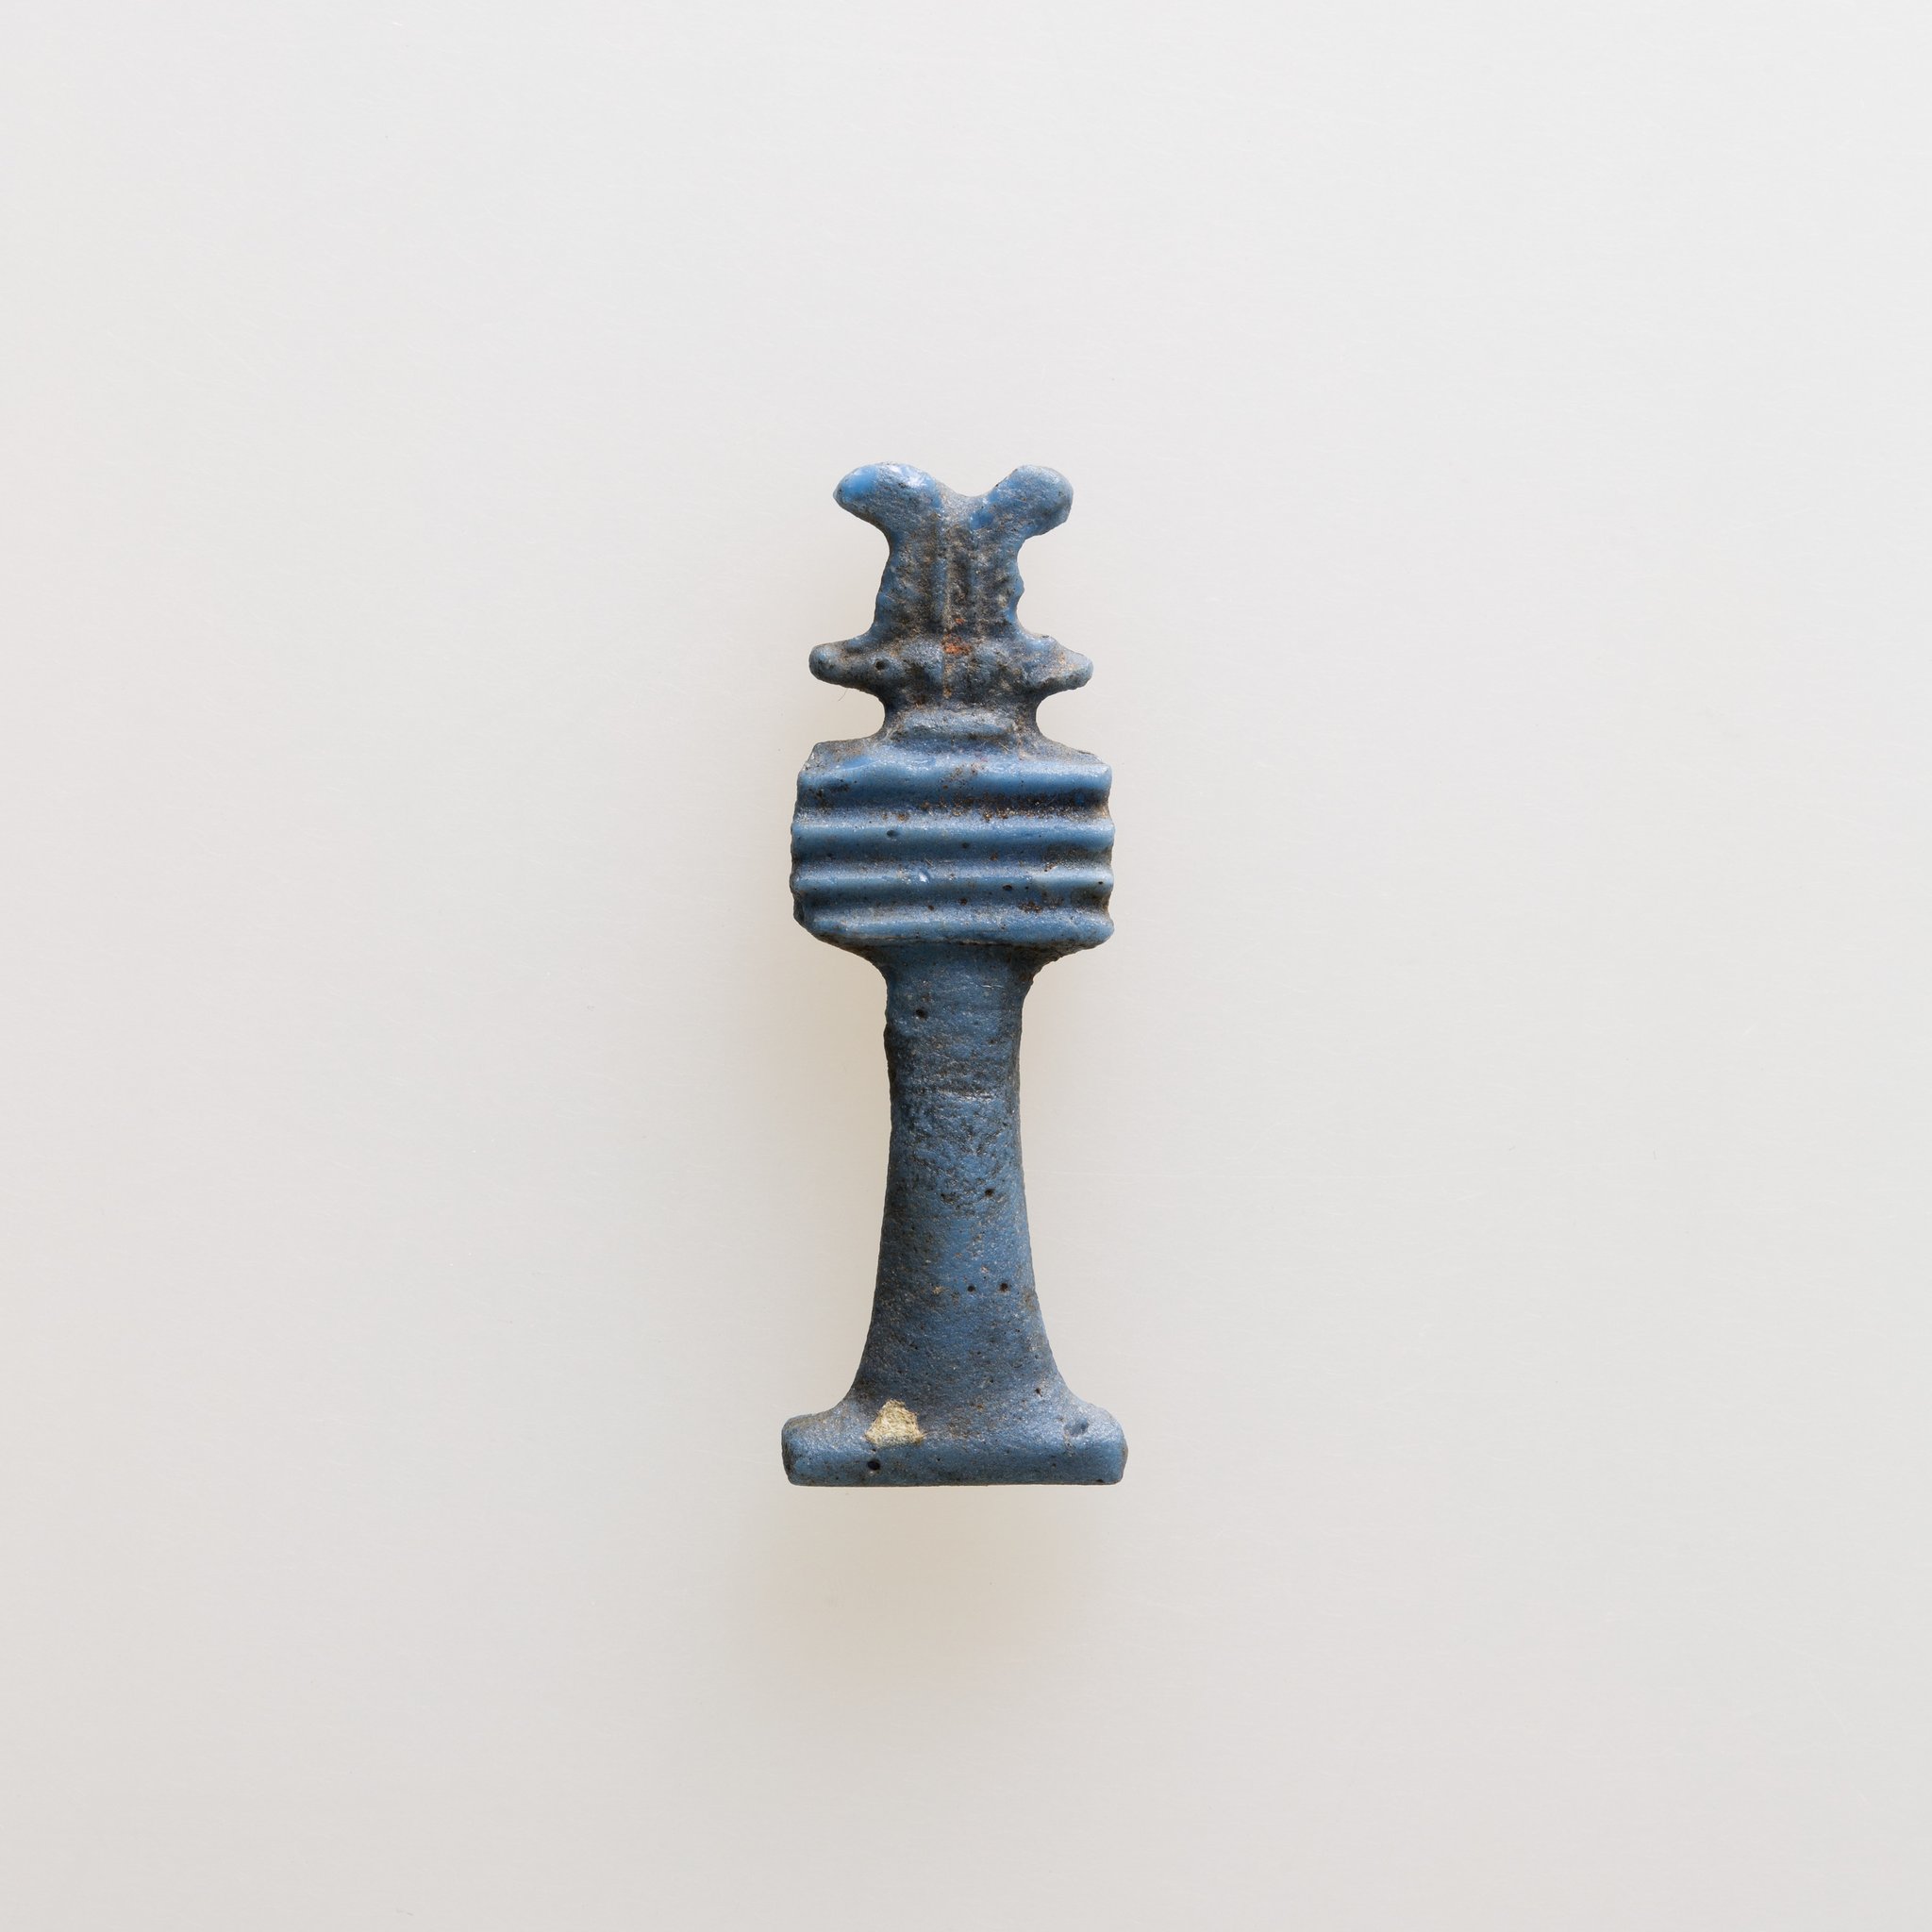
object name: amulet, djed pillar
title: Djed pillar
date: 525-30 BCE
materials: glass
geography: egypt